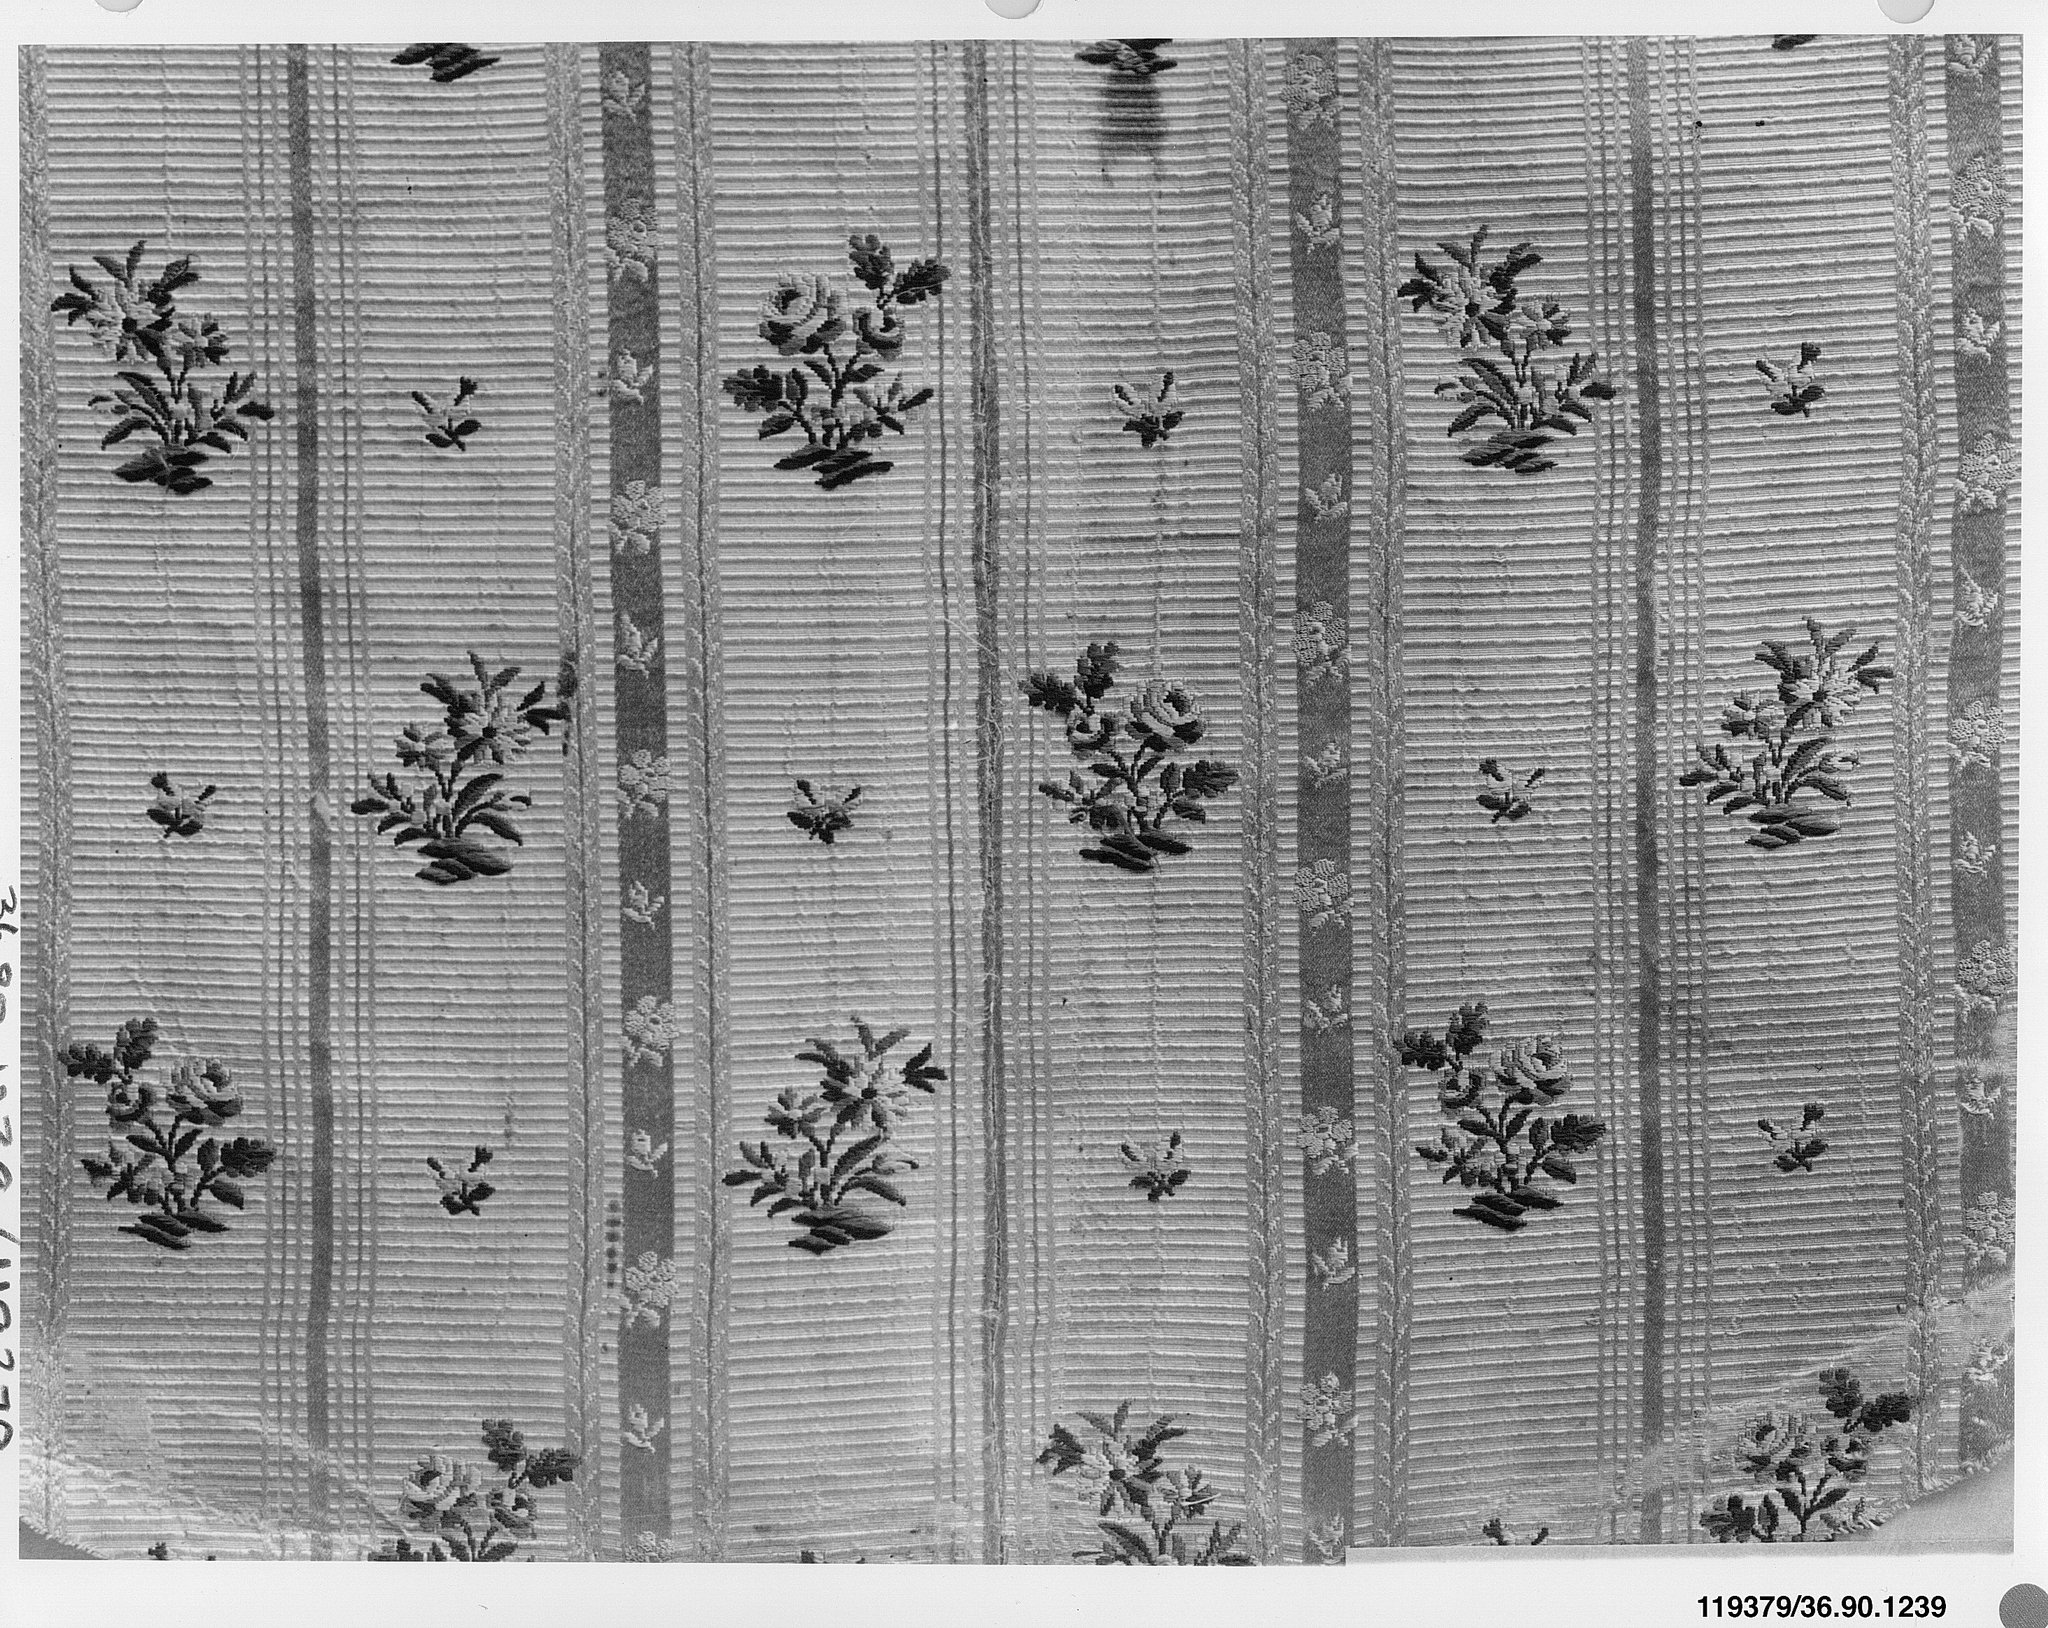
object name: piece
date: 1701-1800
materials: silk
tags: flowers,leaves